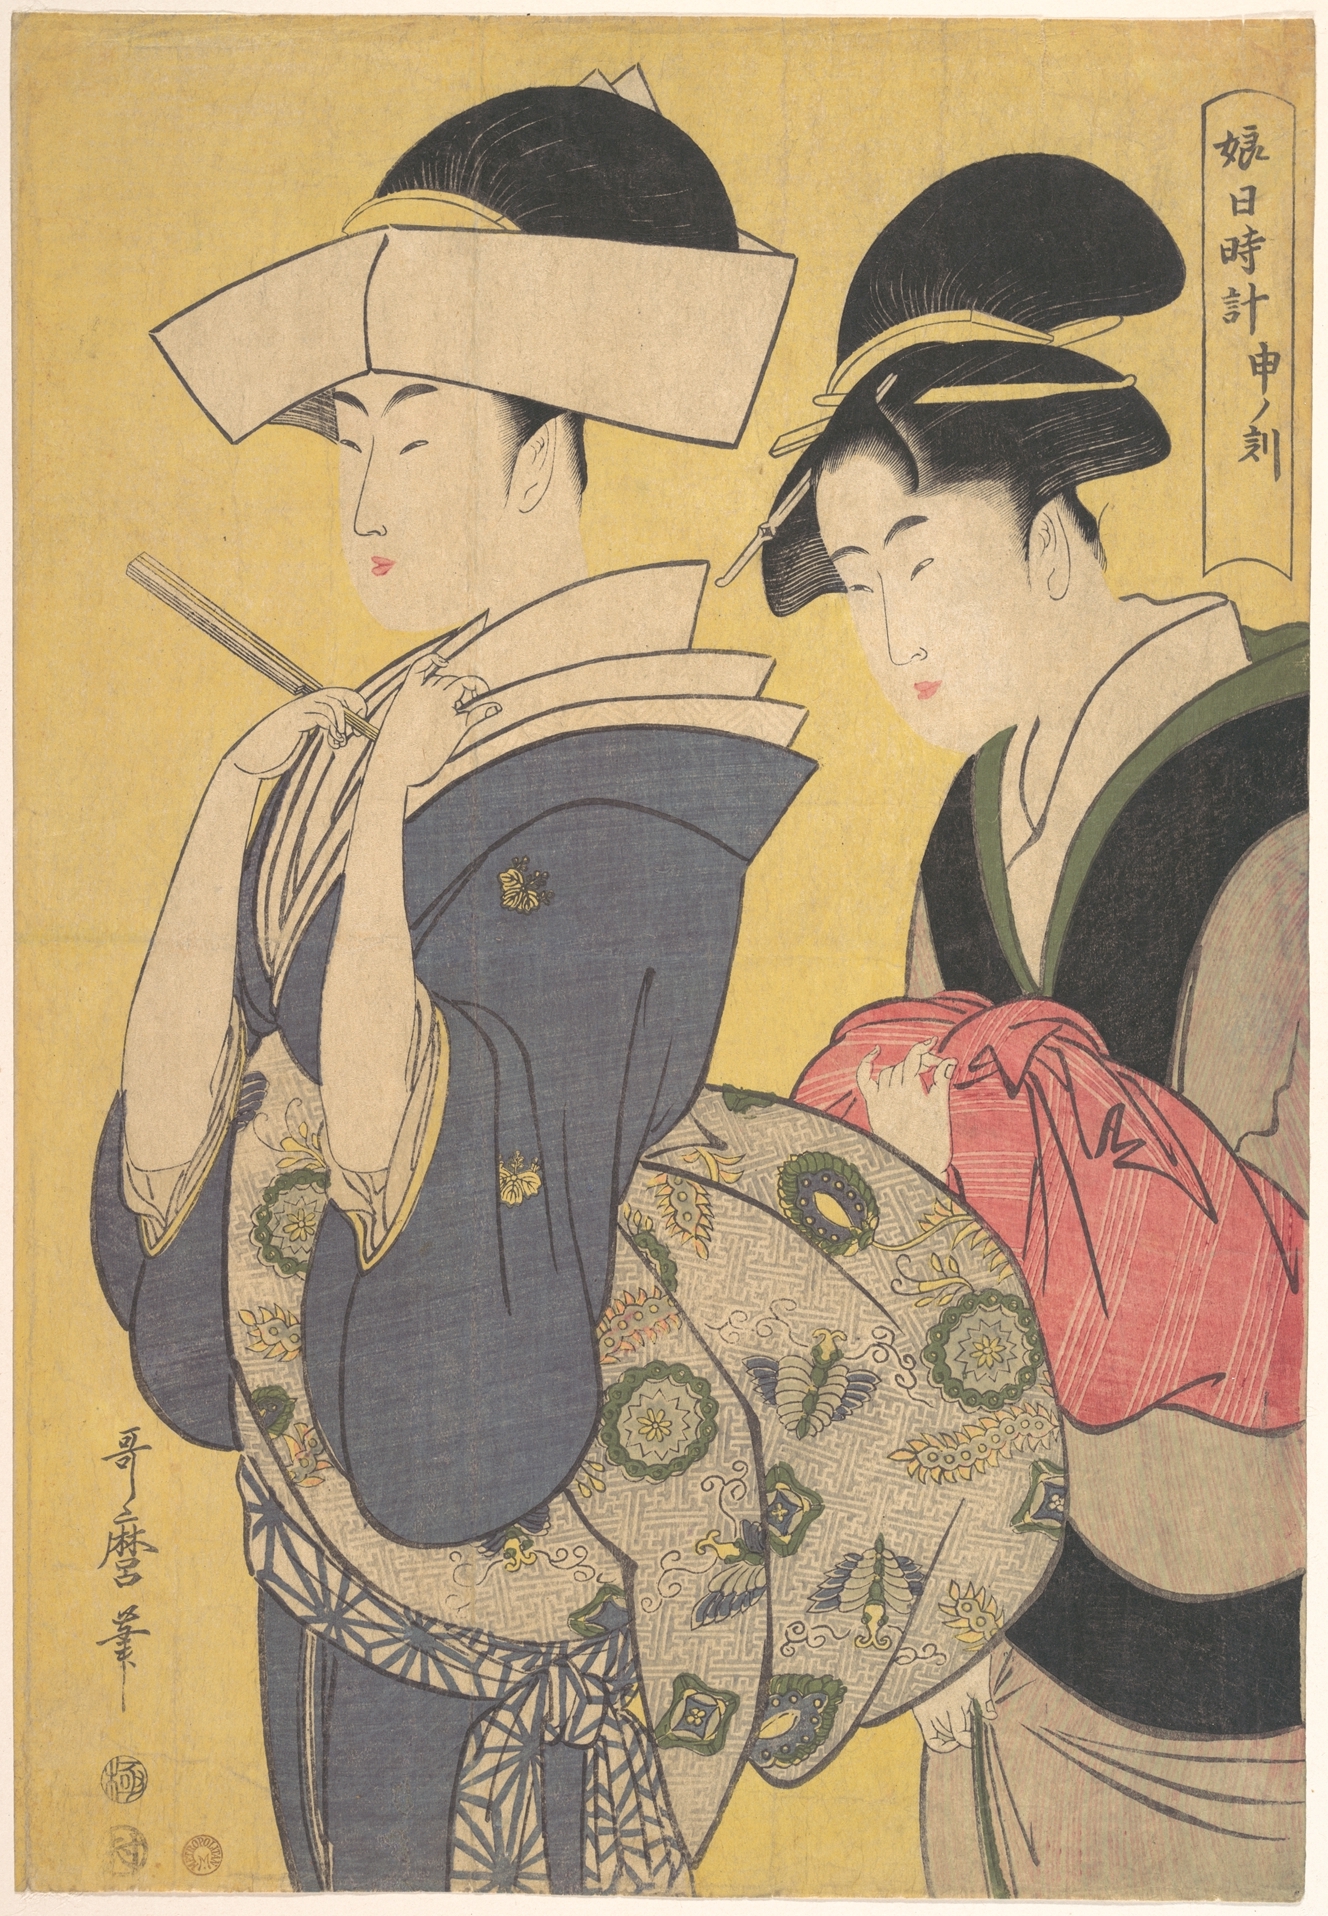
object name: print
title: Seru no Koku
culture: japanese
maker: kitagawa utamaro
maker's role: artist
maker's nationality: japanese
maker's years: 1754-1806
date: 1795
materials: ink, paper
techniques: woodblock print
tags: women